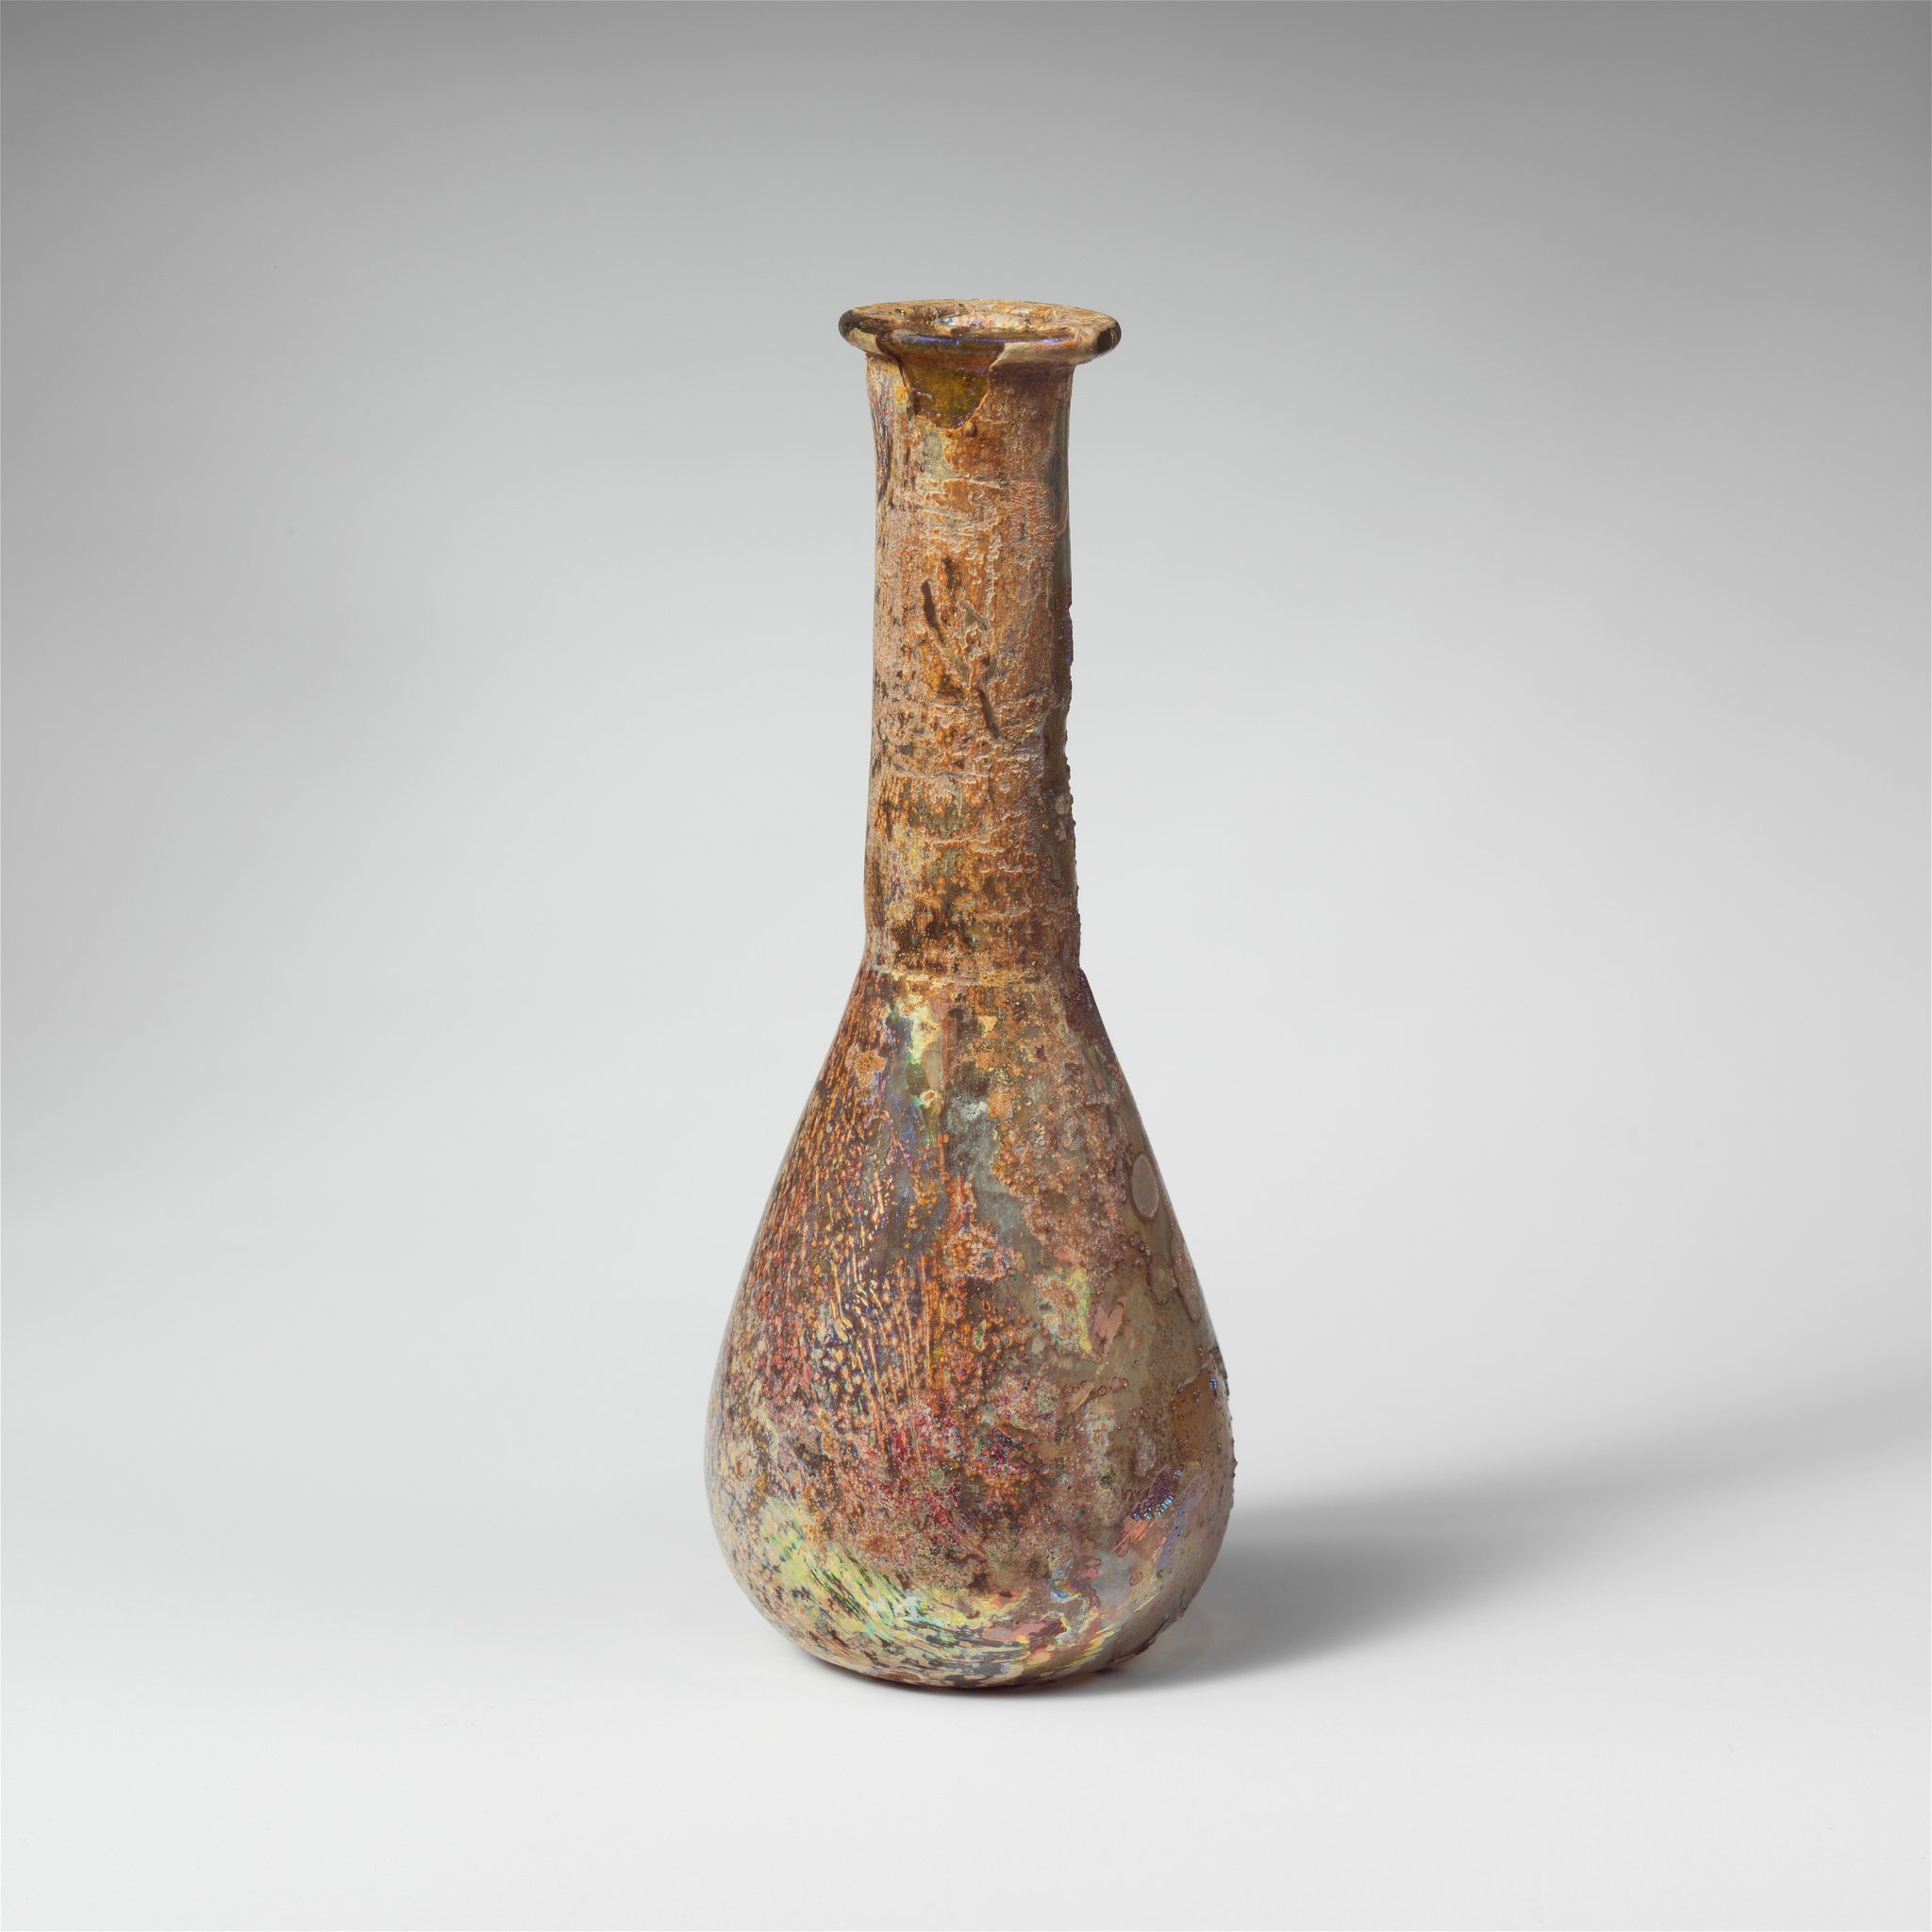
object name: perfume bottle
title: Glass perfume bottle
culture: roman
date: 1-100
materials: glass